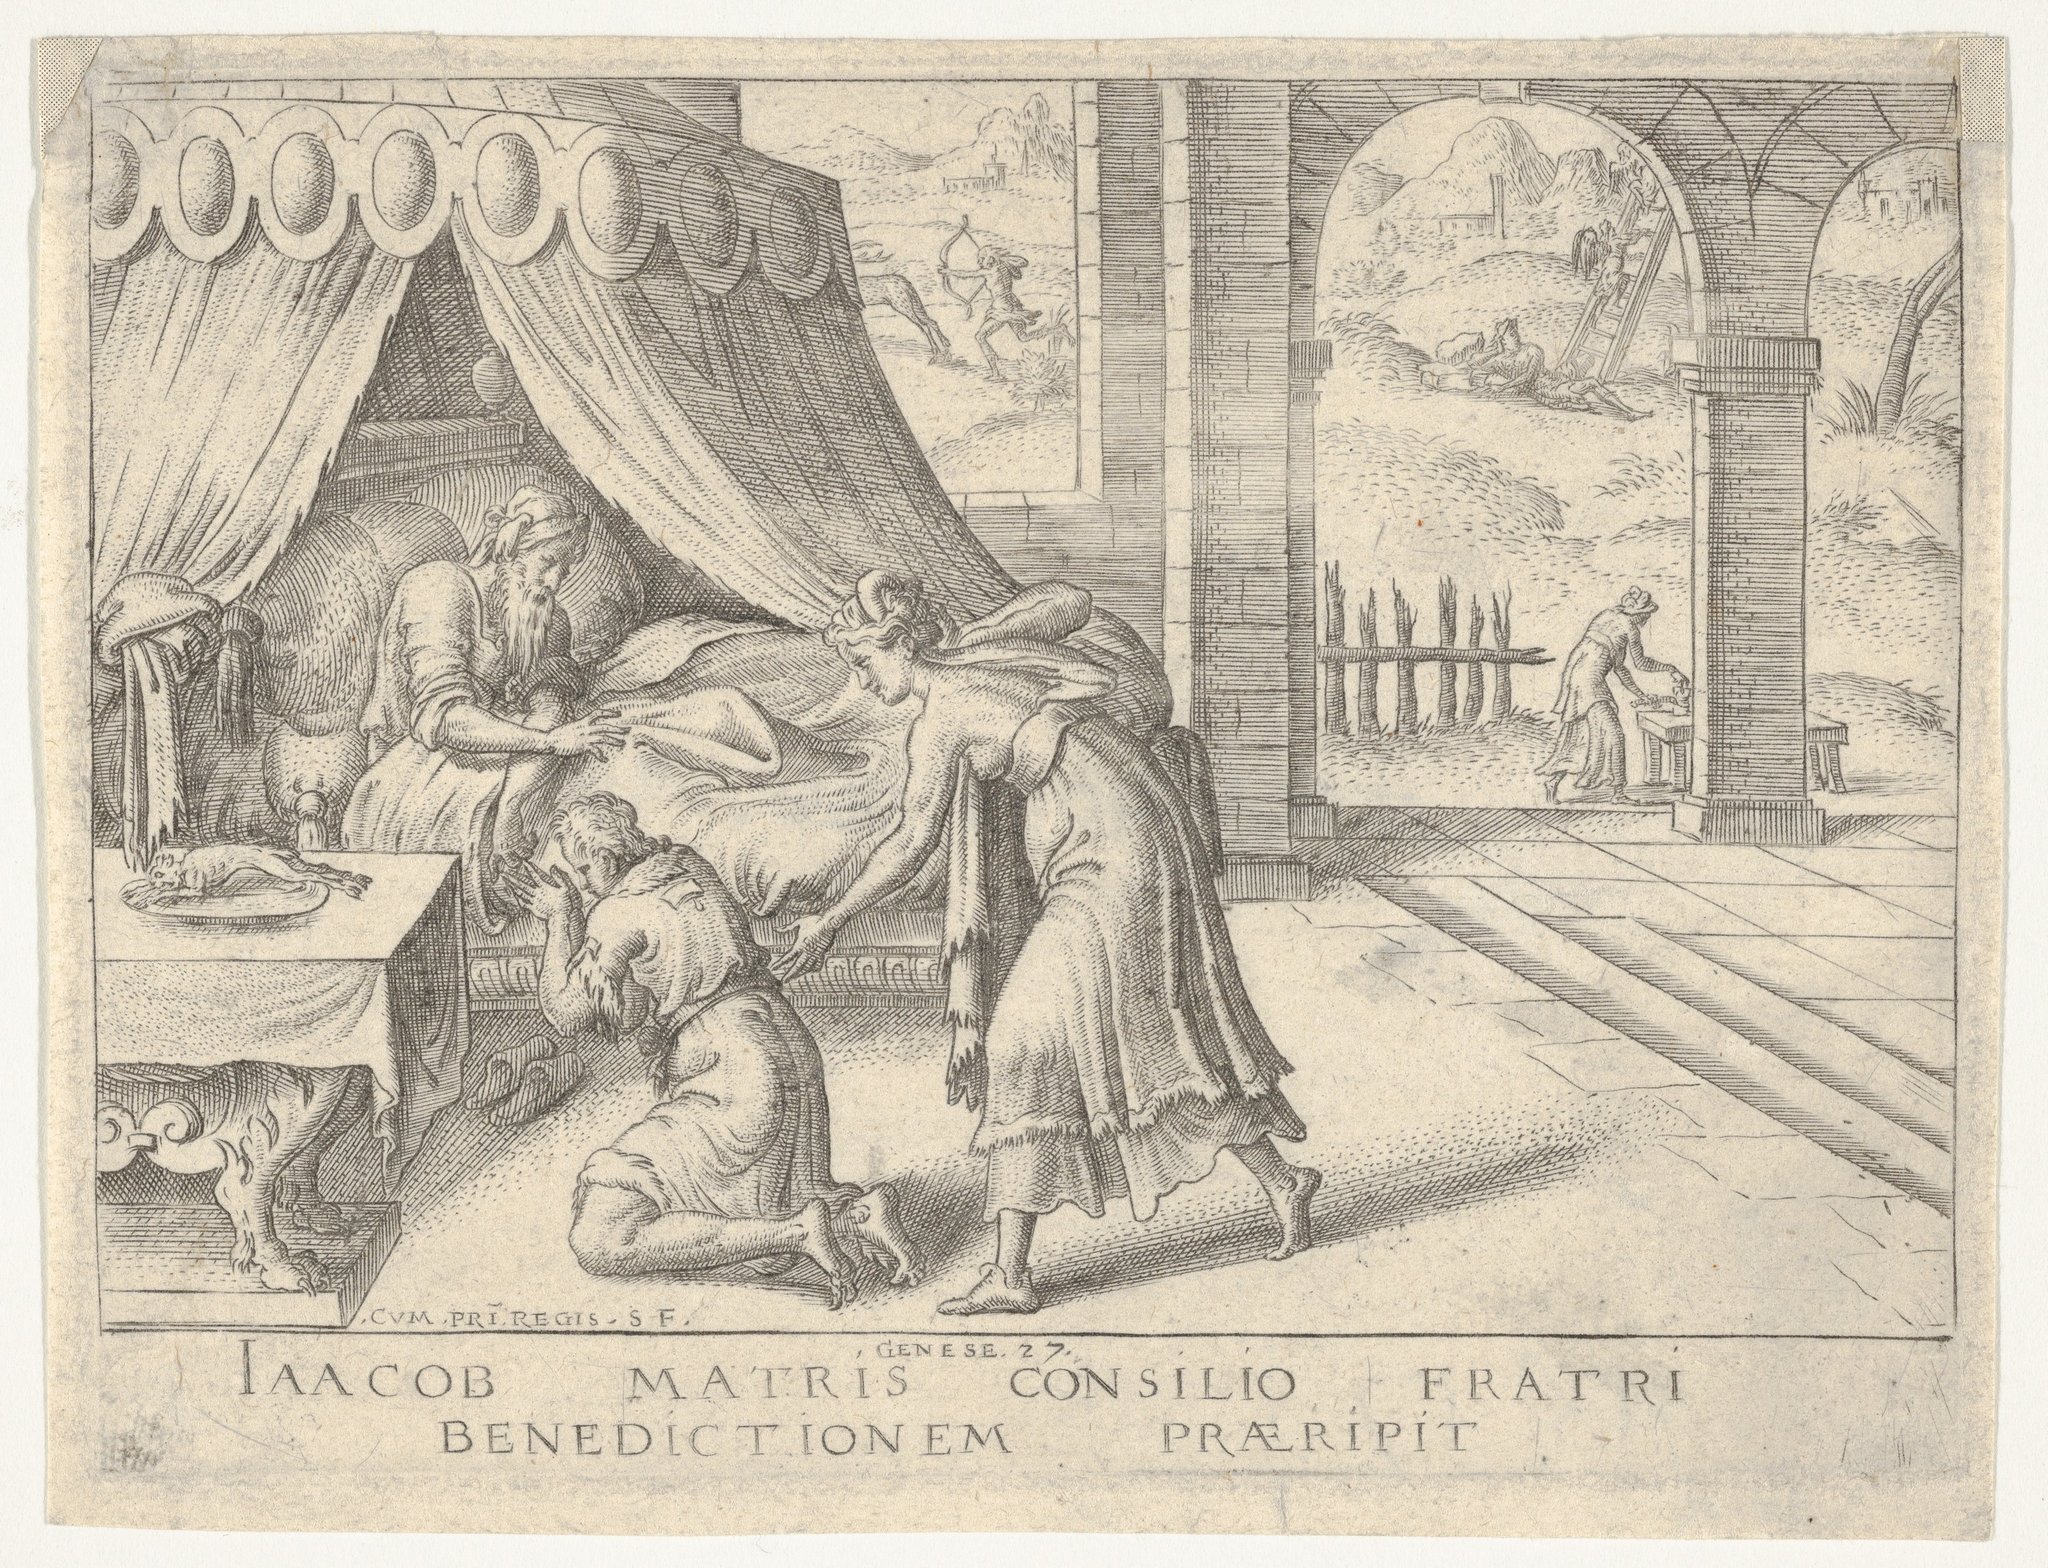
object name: print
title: Isaac Blessing Jacob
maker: etienne delaune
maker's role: artist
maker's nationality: french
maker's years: 1518-1583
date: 1540-1583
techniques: etching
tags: men,women,beds,isaac